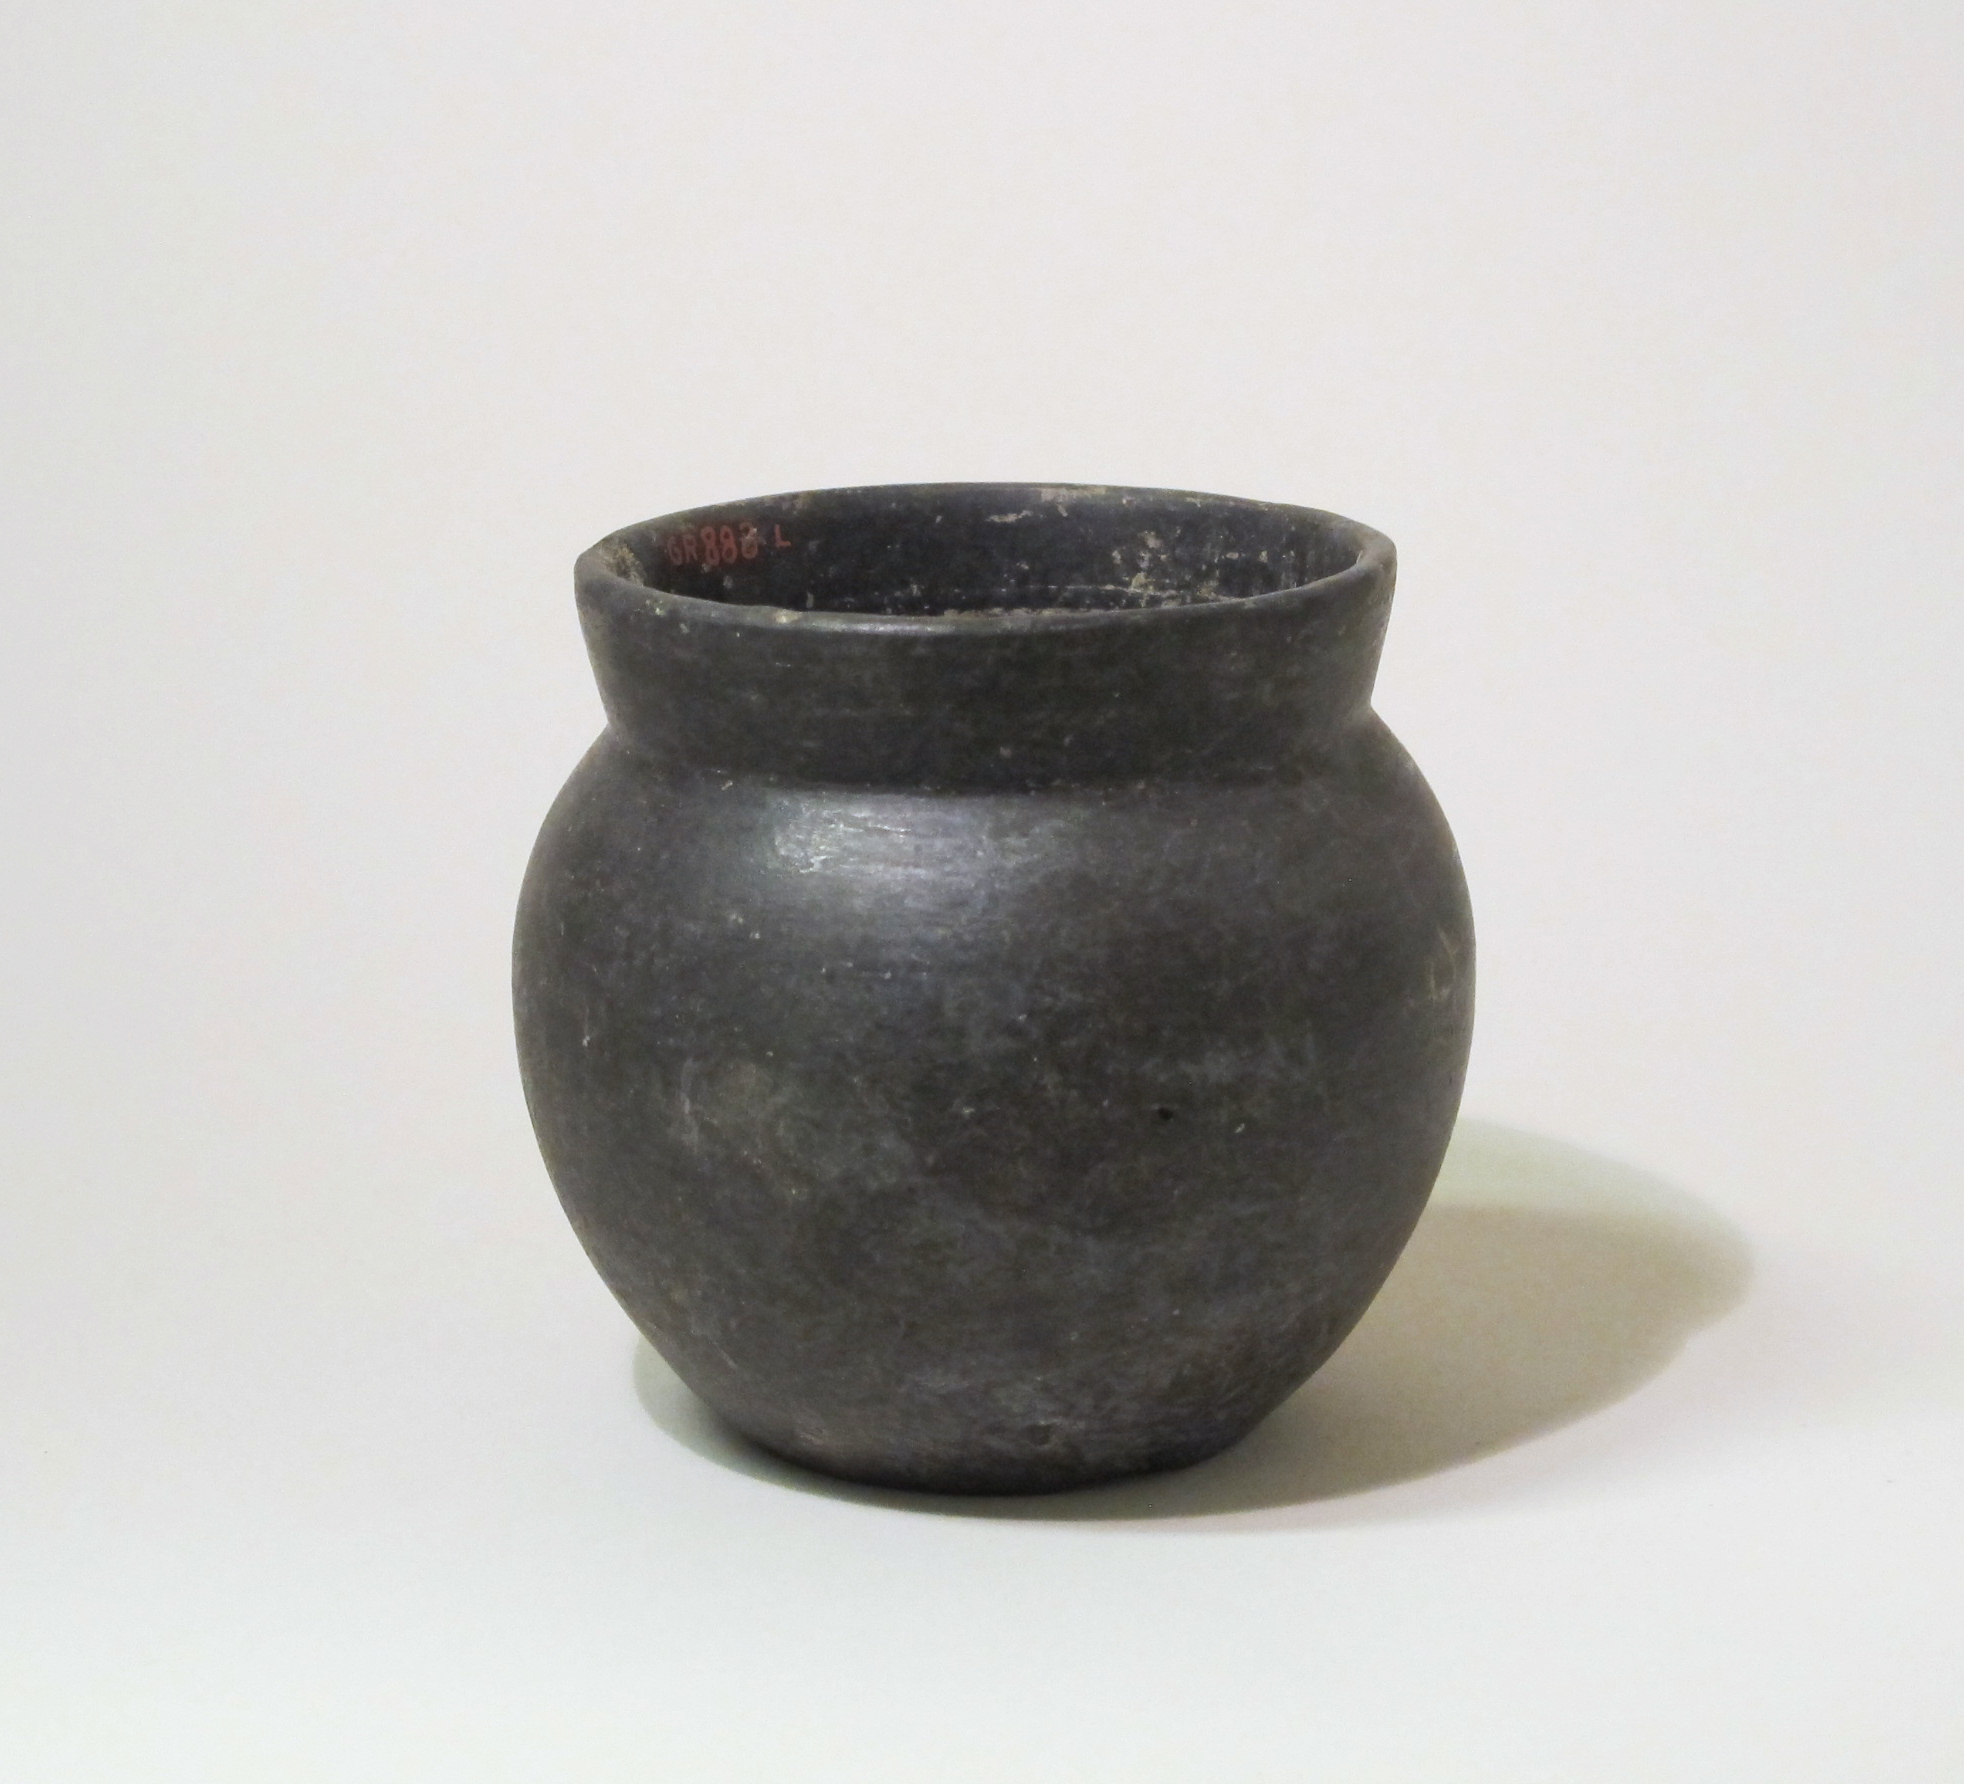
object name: focolare bowl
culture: etruscan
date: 550-501 BCE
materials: terracotta